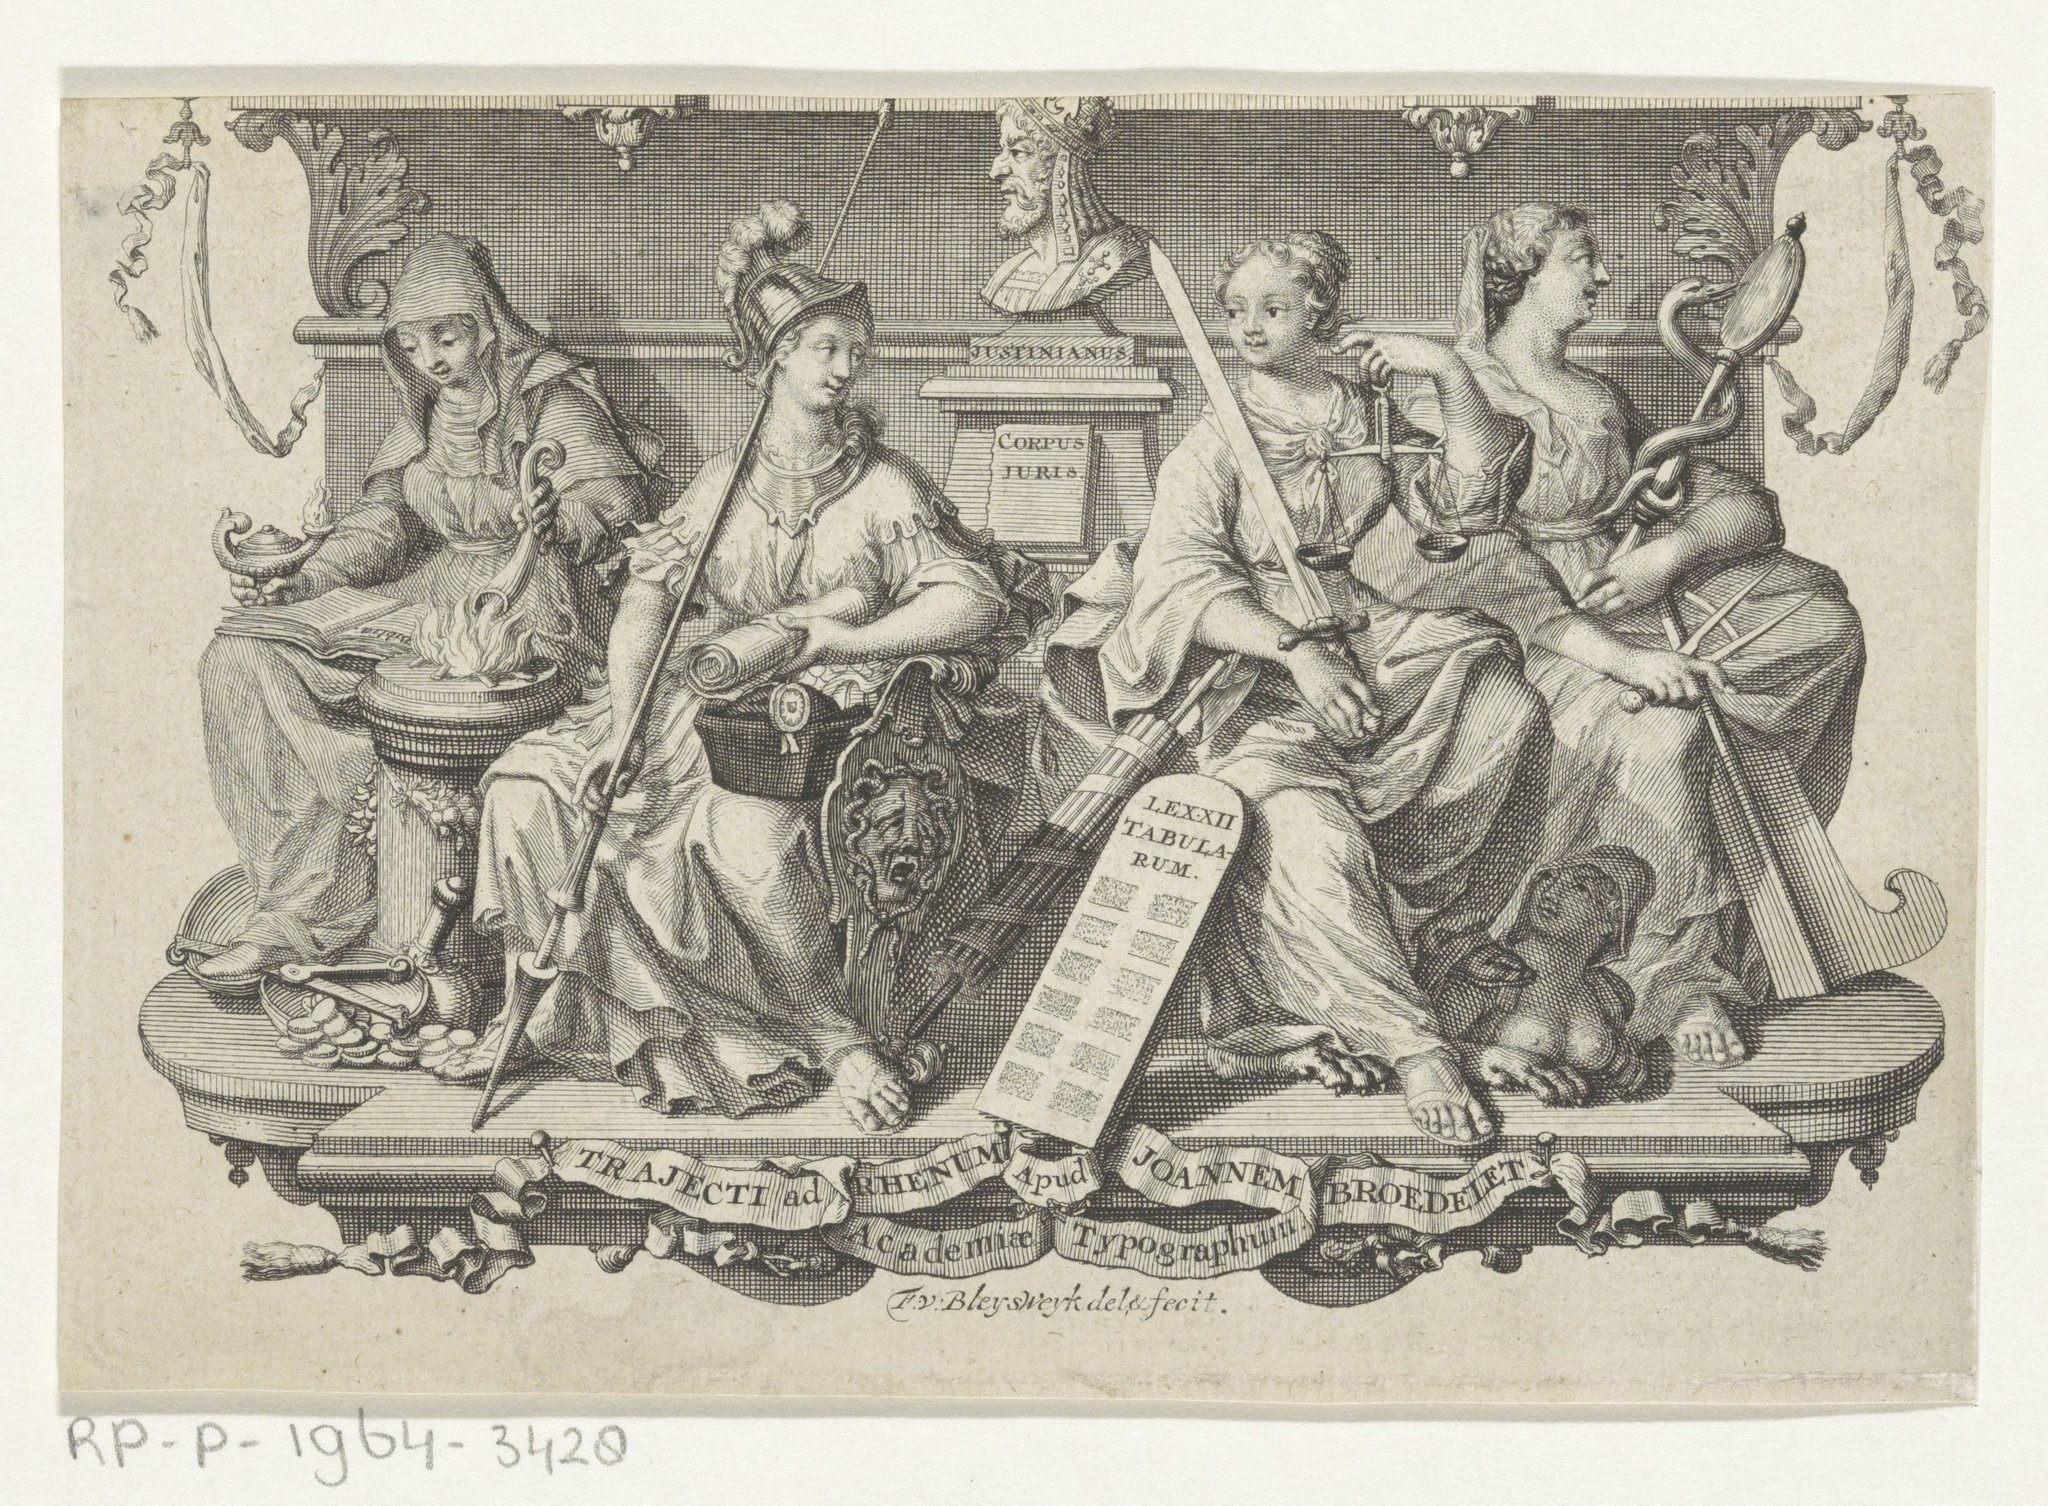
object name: print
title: Allegorie met Minerva en deugden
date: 1728-1771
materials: paper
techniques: etching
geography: utrecht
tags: temperance, 'temperantia'; 'temperanza' (ripa) ~ one of the four cardinal virtues, justice, 'justitia'; 'giustitia divina' (ripa) ~ one of the four cardinal virtues, prudence, 'prudentia'; 'prudenza' (ripa) ~ one of the four cardinal virtues, (story of) minerva (pallas, athena), utrecht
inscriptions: collector's mark: Lugt 2760, collector's mark: Lugt 2228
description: Minerva zittend met drie personificaties van deugden: Matigheid, Rechtvaardigheid en Voorzichtigheid. Onderste deel van een prent met gezicht op de stad Utrecht met het silhouet van de Domkerk.